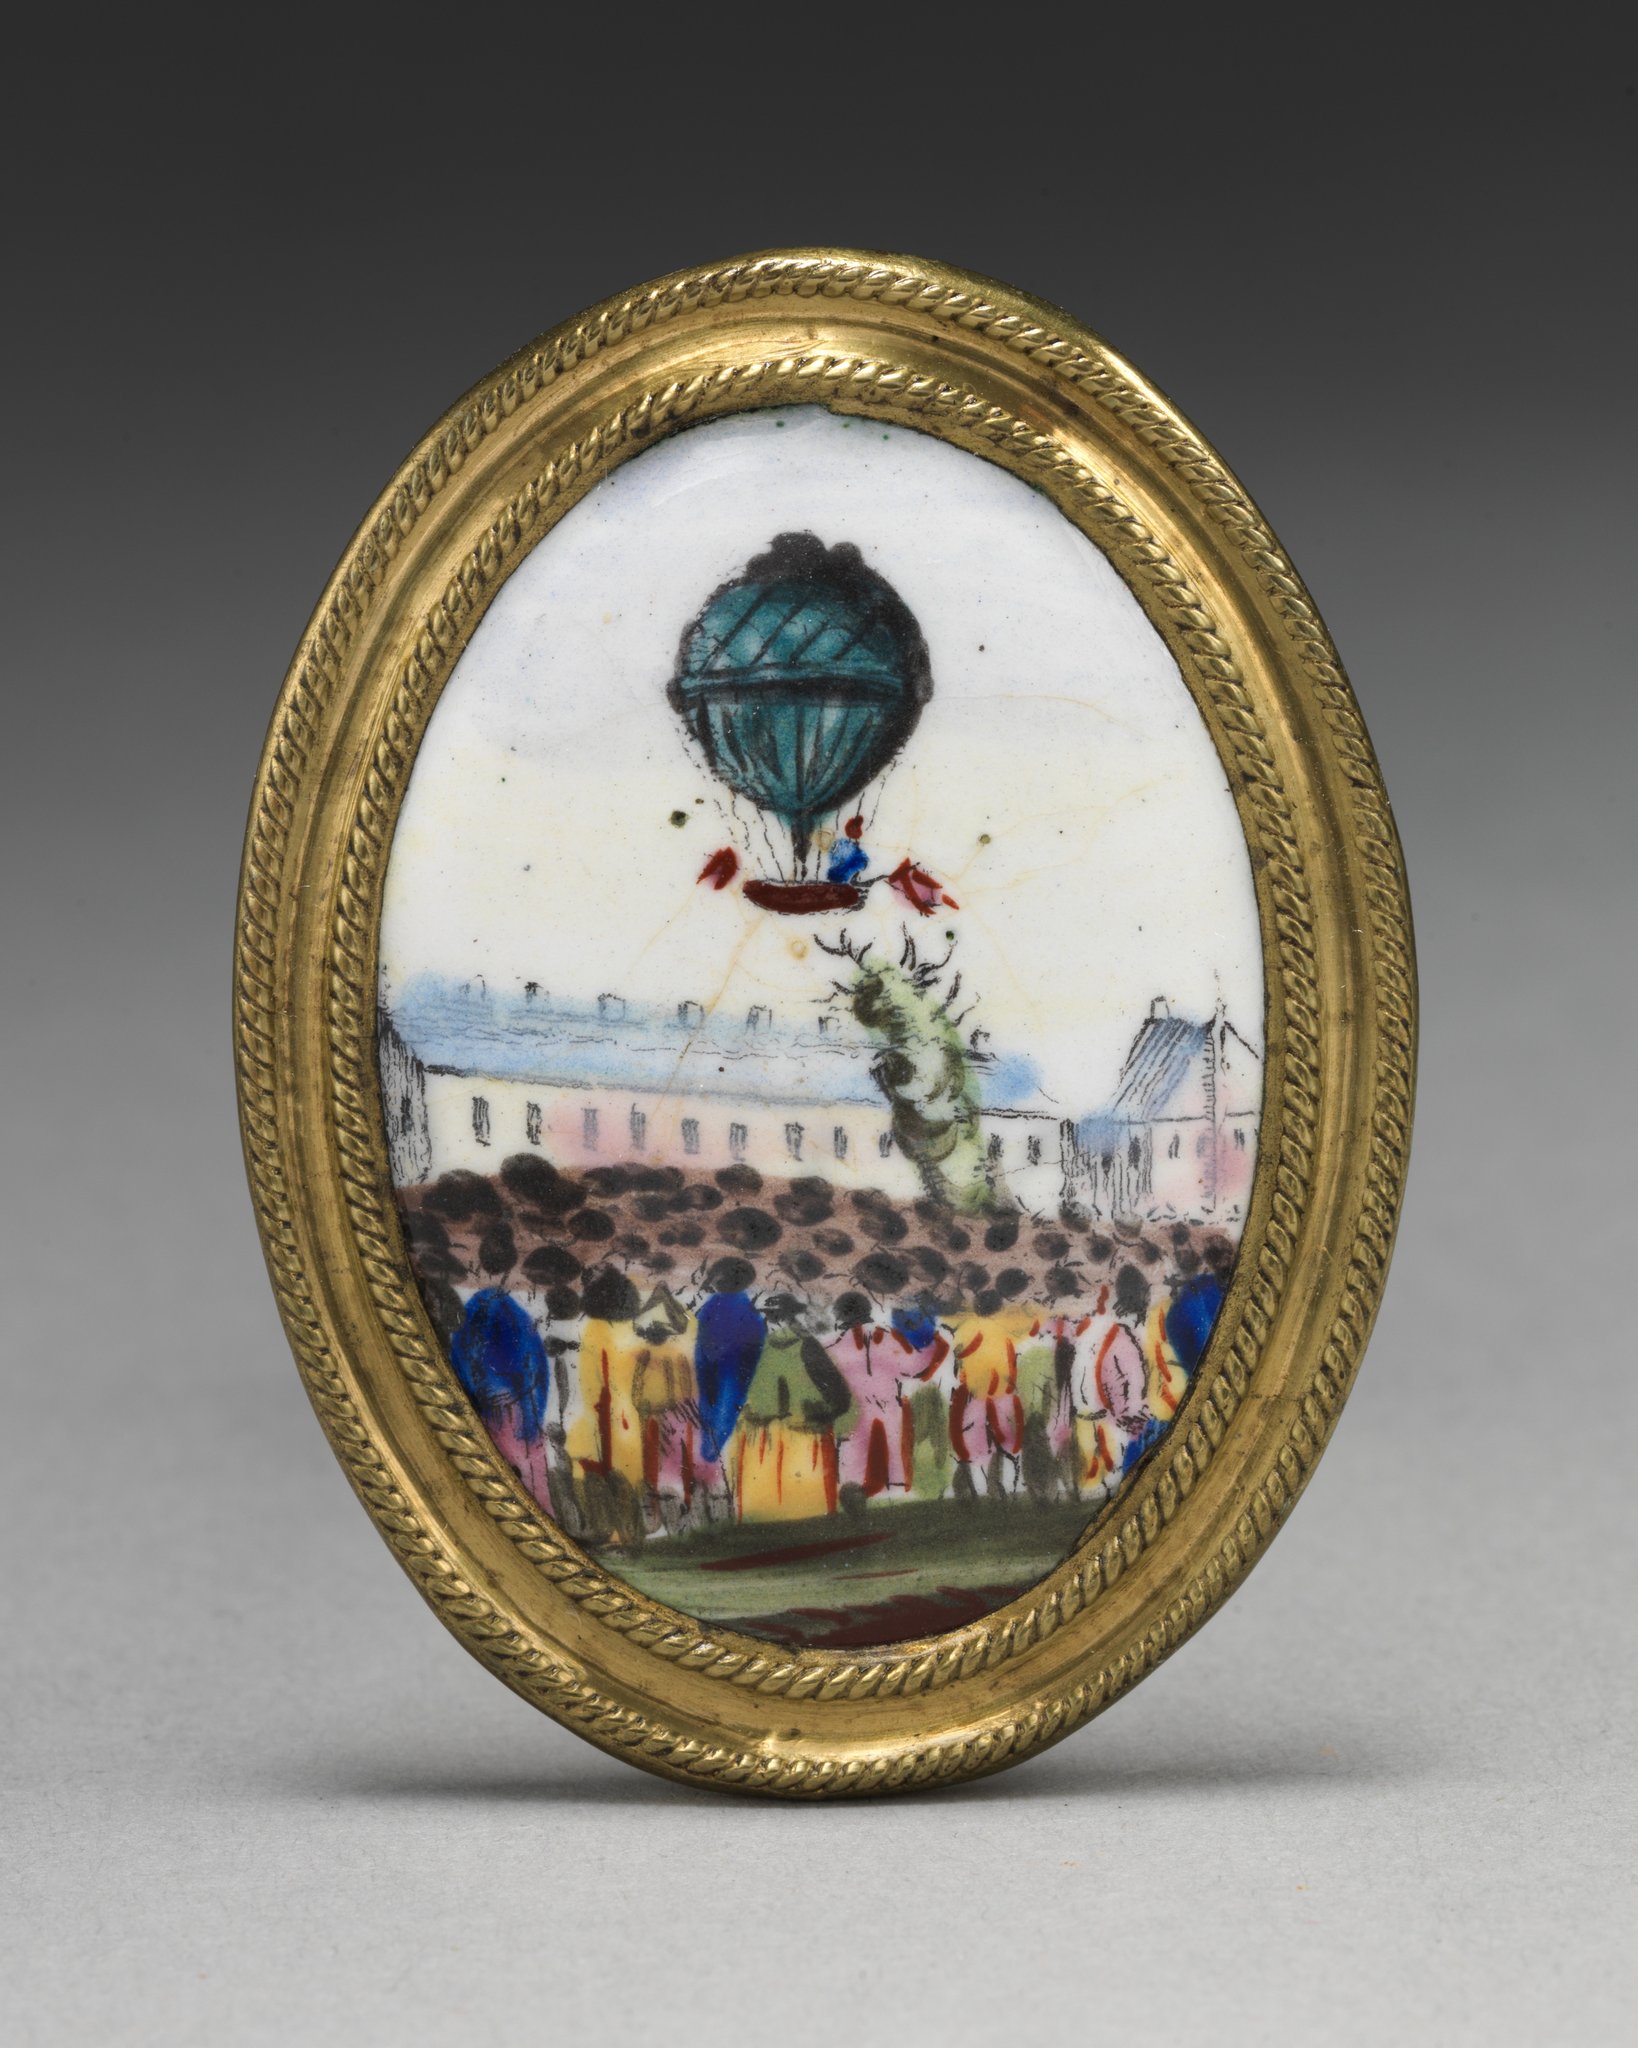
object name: knob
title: Knob depicting a balloon ascent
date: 1783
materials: brass, copper, enamel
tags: hot air balloons